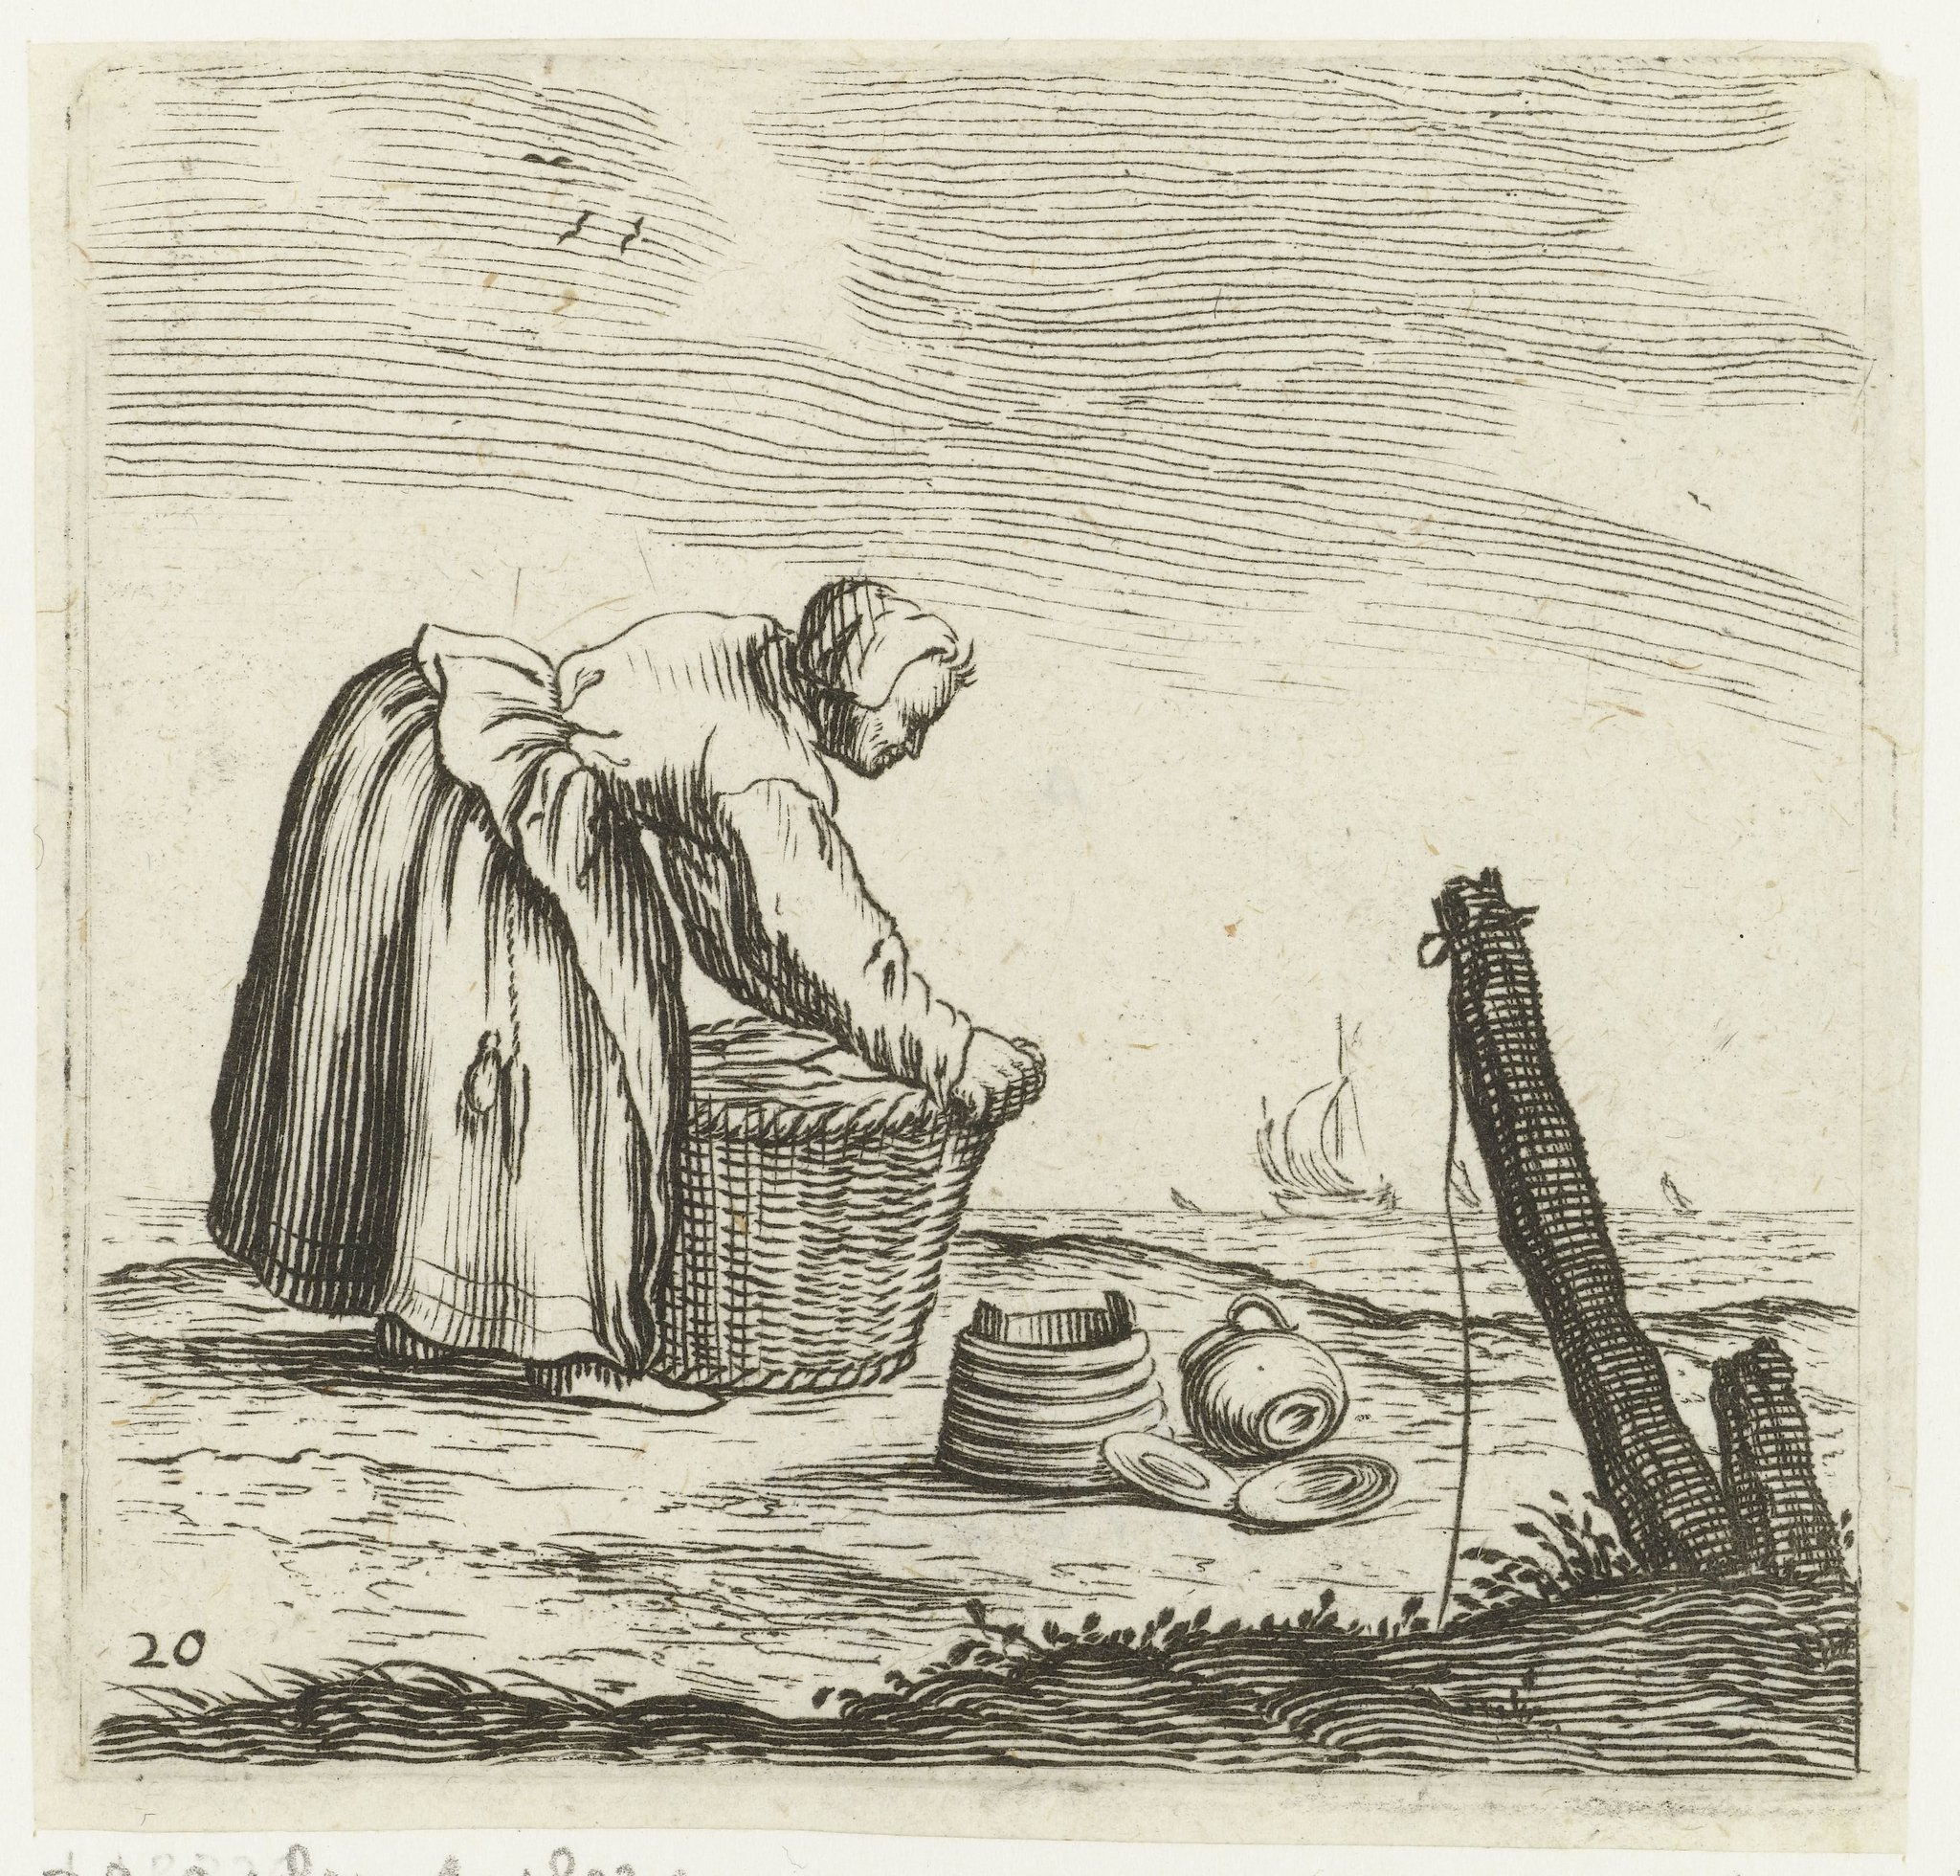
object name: print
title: Verscheyden Stranden en water gesichten gedaen door Jan Percelles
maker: gillis van scheyndel (i)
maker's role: draughtsman, print maker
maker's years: 1595-1660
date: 1603-1653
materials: paper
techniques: etching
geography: northern netherlands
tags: dune coast, container made of plant material other than wood: basket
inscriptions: collector's mark: Lugt 2228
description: De prent is op een gegeven moment toegevoegd aan de serie "Verscheyden Stranden en water gesichten gedaen door Jan Percelles". Op dat moment is het serienummer gewijzigd.